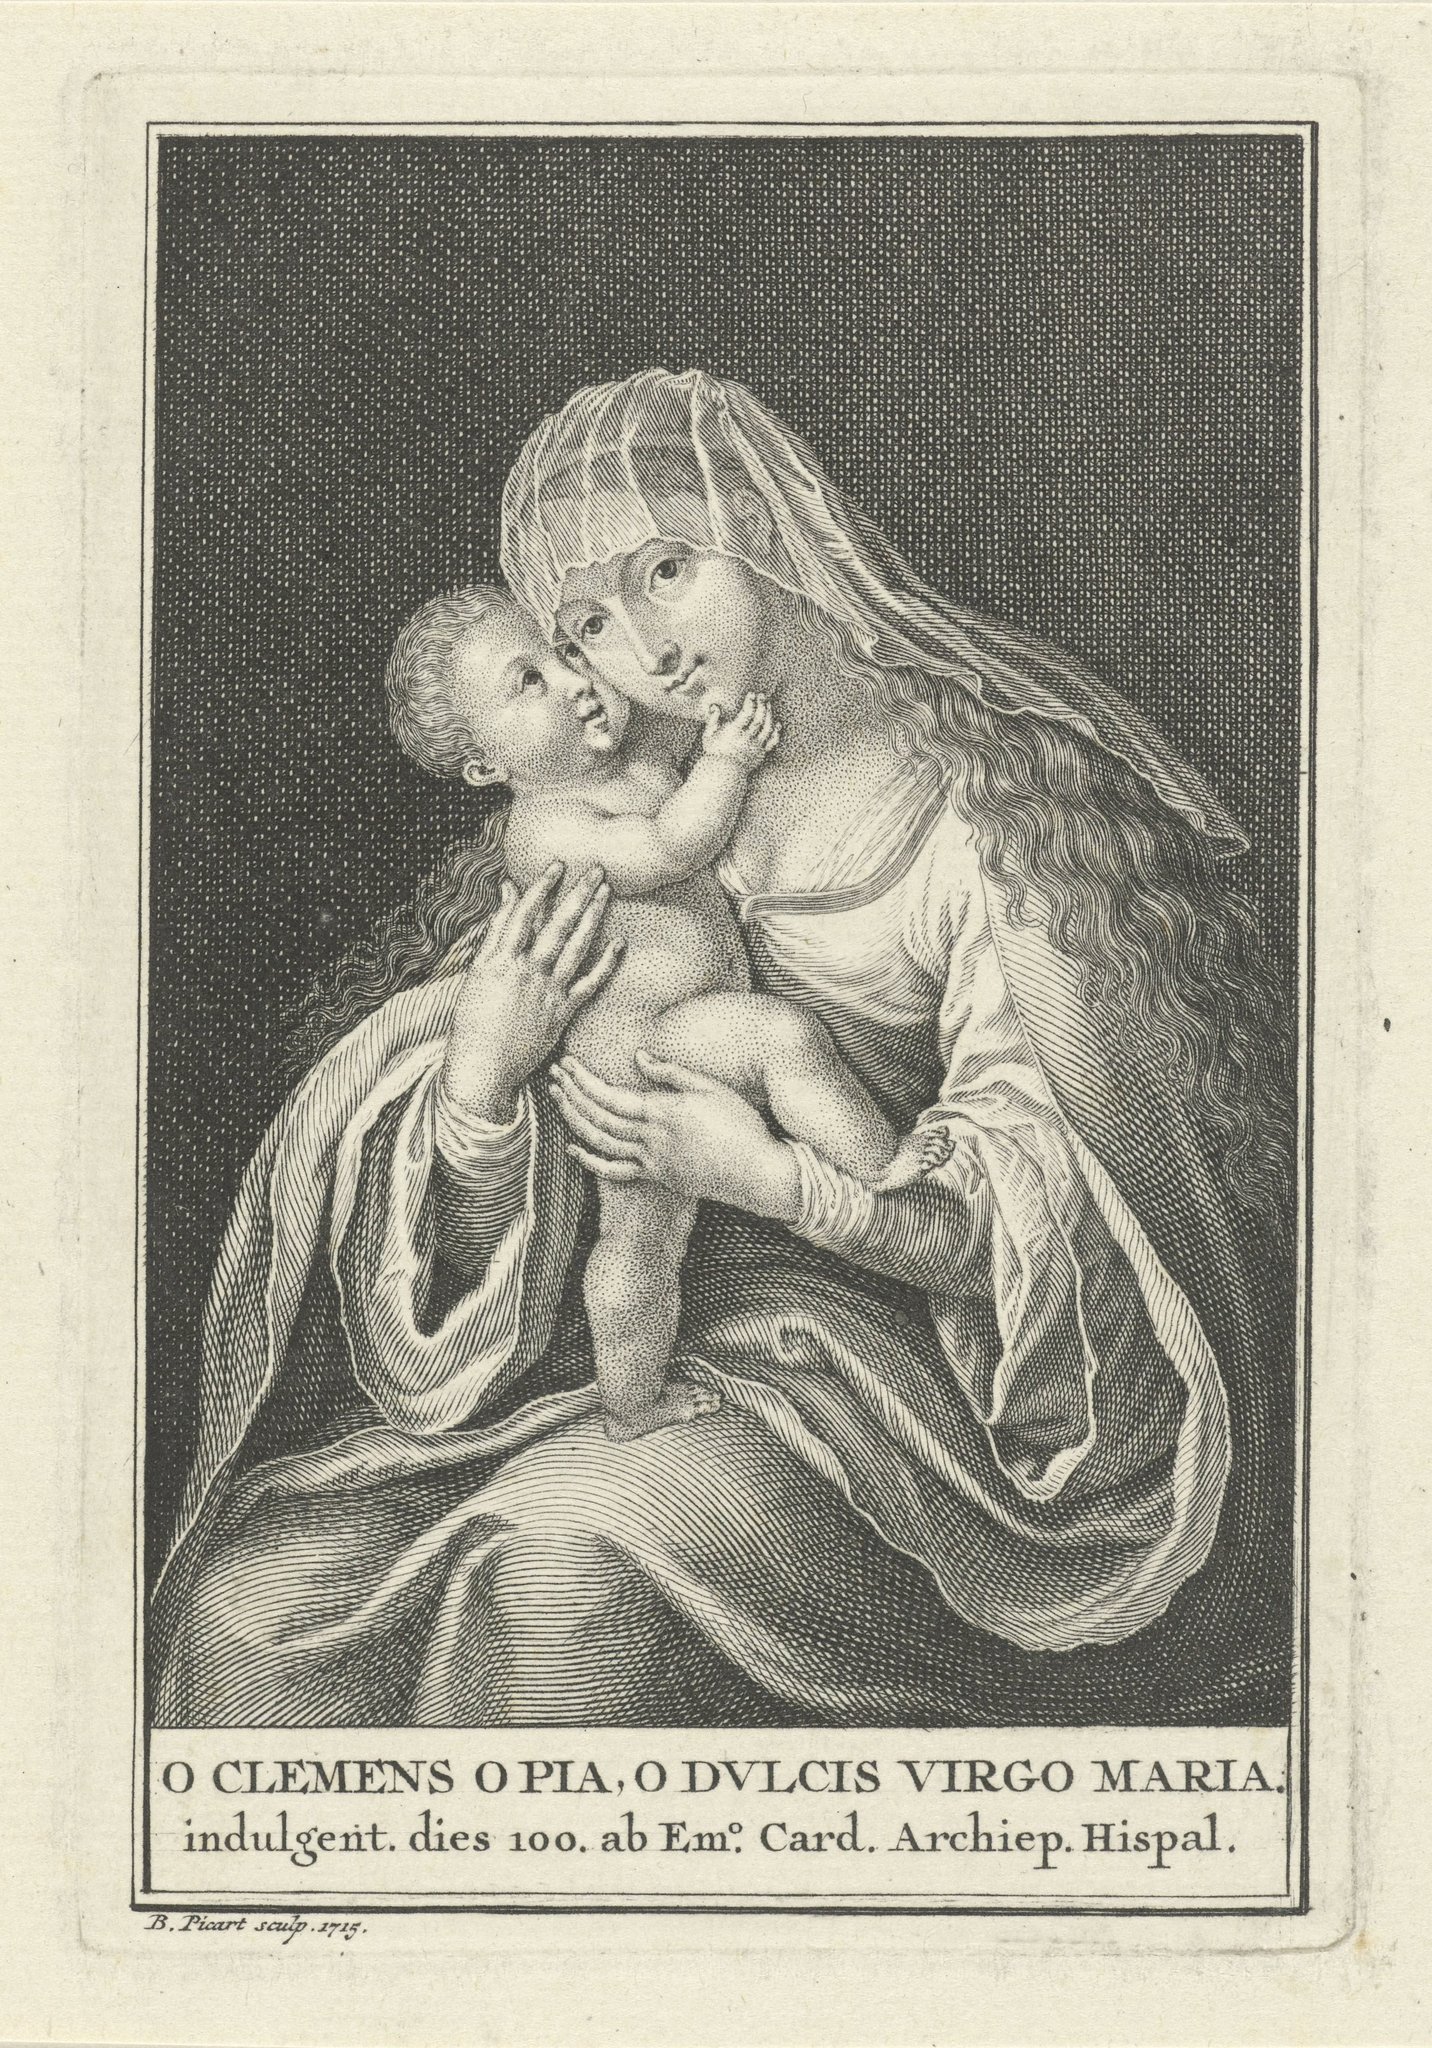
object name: print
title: Maria met kind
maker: bernard picart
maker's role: draughtsman, print maker, publisher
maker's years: 1673-1733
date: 1715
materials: paper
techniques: engraving, etching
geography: amsterdam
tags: mary sitting or enthroned, the christ-child in front of her, standing in her lap (or in front of her bosom)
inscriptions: collector's mark: Lugt 240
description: Maria met in de armen het Christuskind dat zich opheft om zijn moeder te kussen. In de marge een tweeregelig onderschrift in het Latijn.